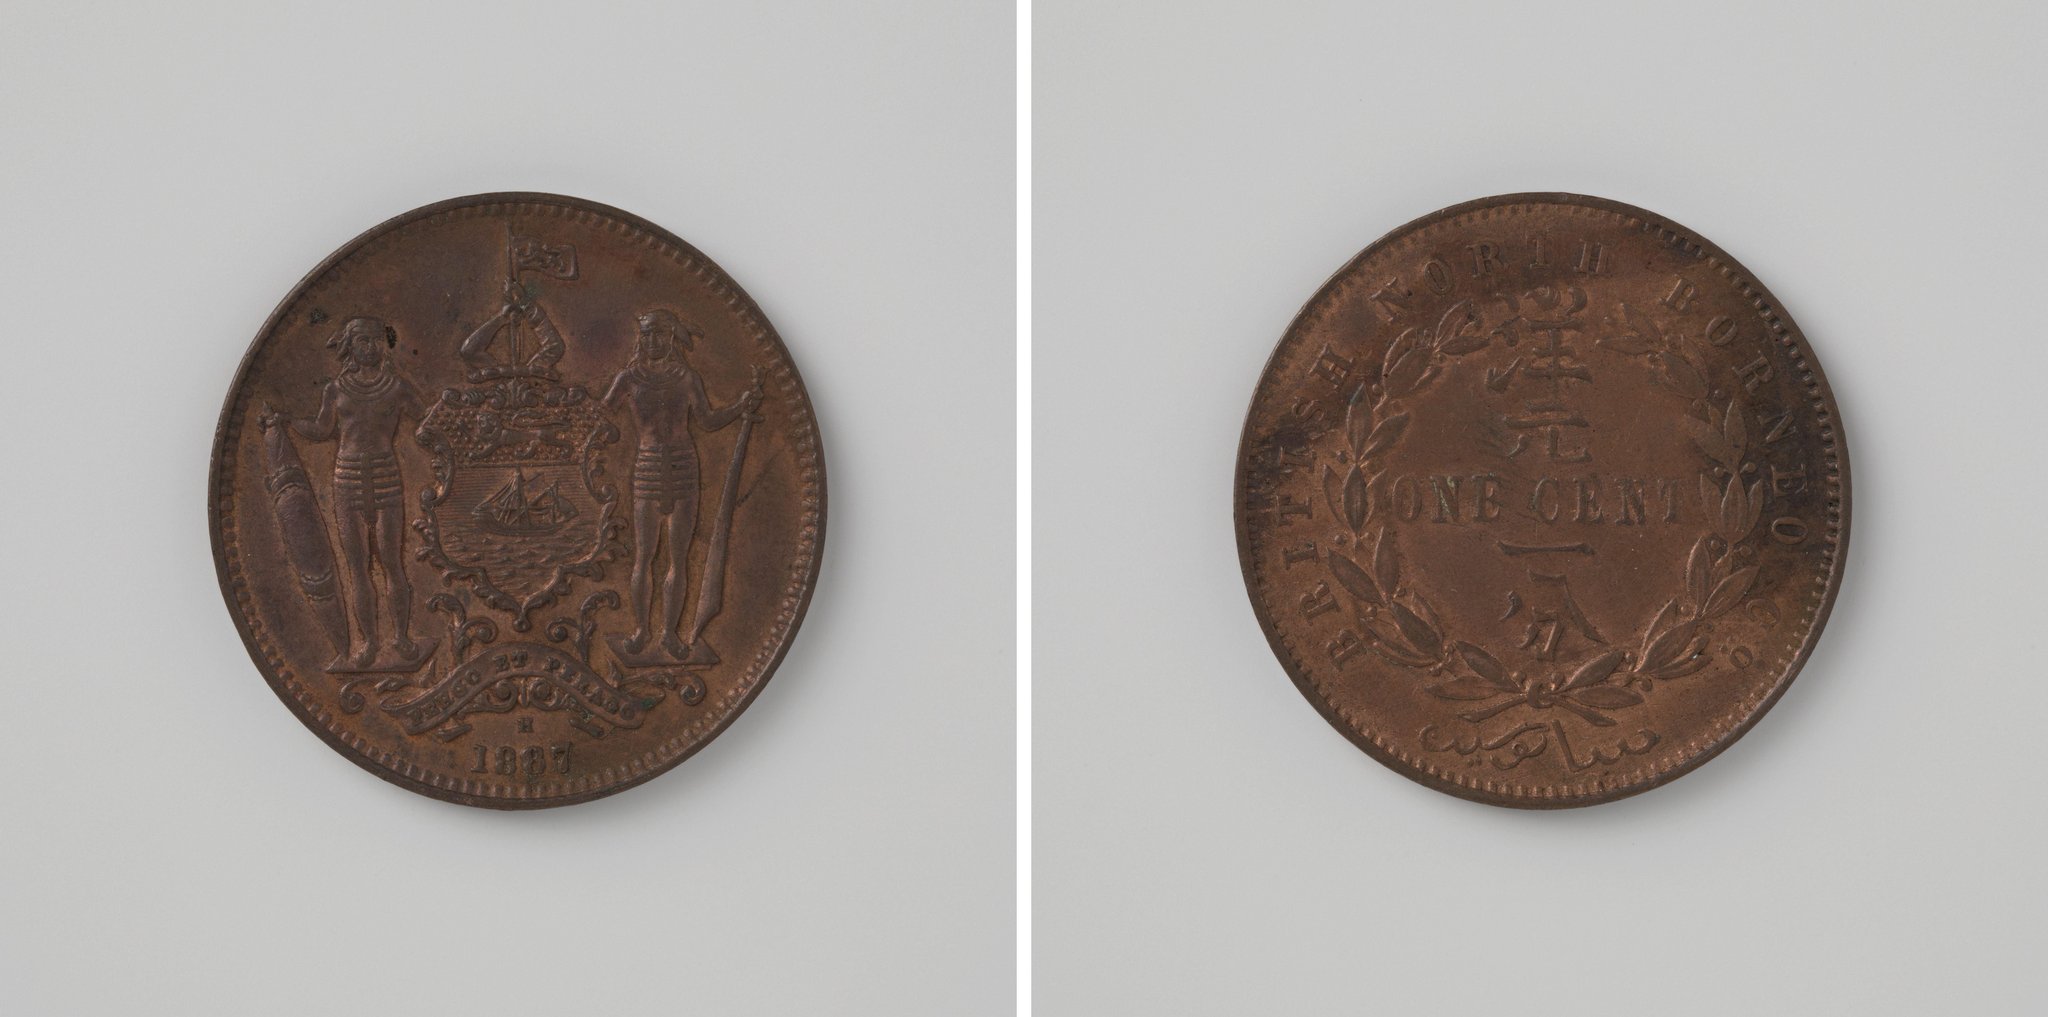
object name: coin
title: Cent van de British North Borneo Company, 1887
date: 1887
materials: bronze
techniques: striking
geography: birmingham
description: Bronzen munt. Voorzijde: door twee inboorlingen als schildhouders gehouden versierd samengesteld wapenschild met wapenspreuk. Daaronder letter H [=Heaton], waaronder jaartal. Keerzijde: tussen twee samengebonden takken waarde-aanduiding in het Chinees in twee regels en in het Engels in een regel. Onderaan waarde-aanduiding in het Maleis in Arabisch schrift. Gladde rand.